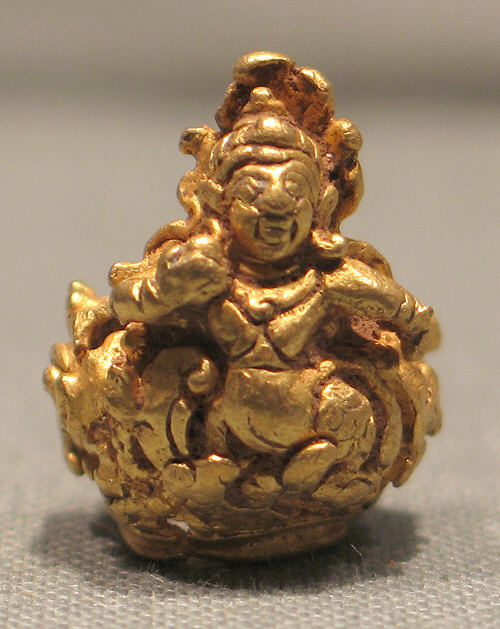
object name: rod finial clip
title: Rod Finial Clip with Vishnu on Garuda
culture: indonesian, javanese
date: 701-933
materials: gold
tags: birds,vishnu